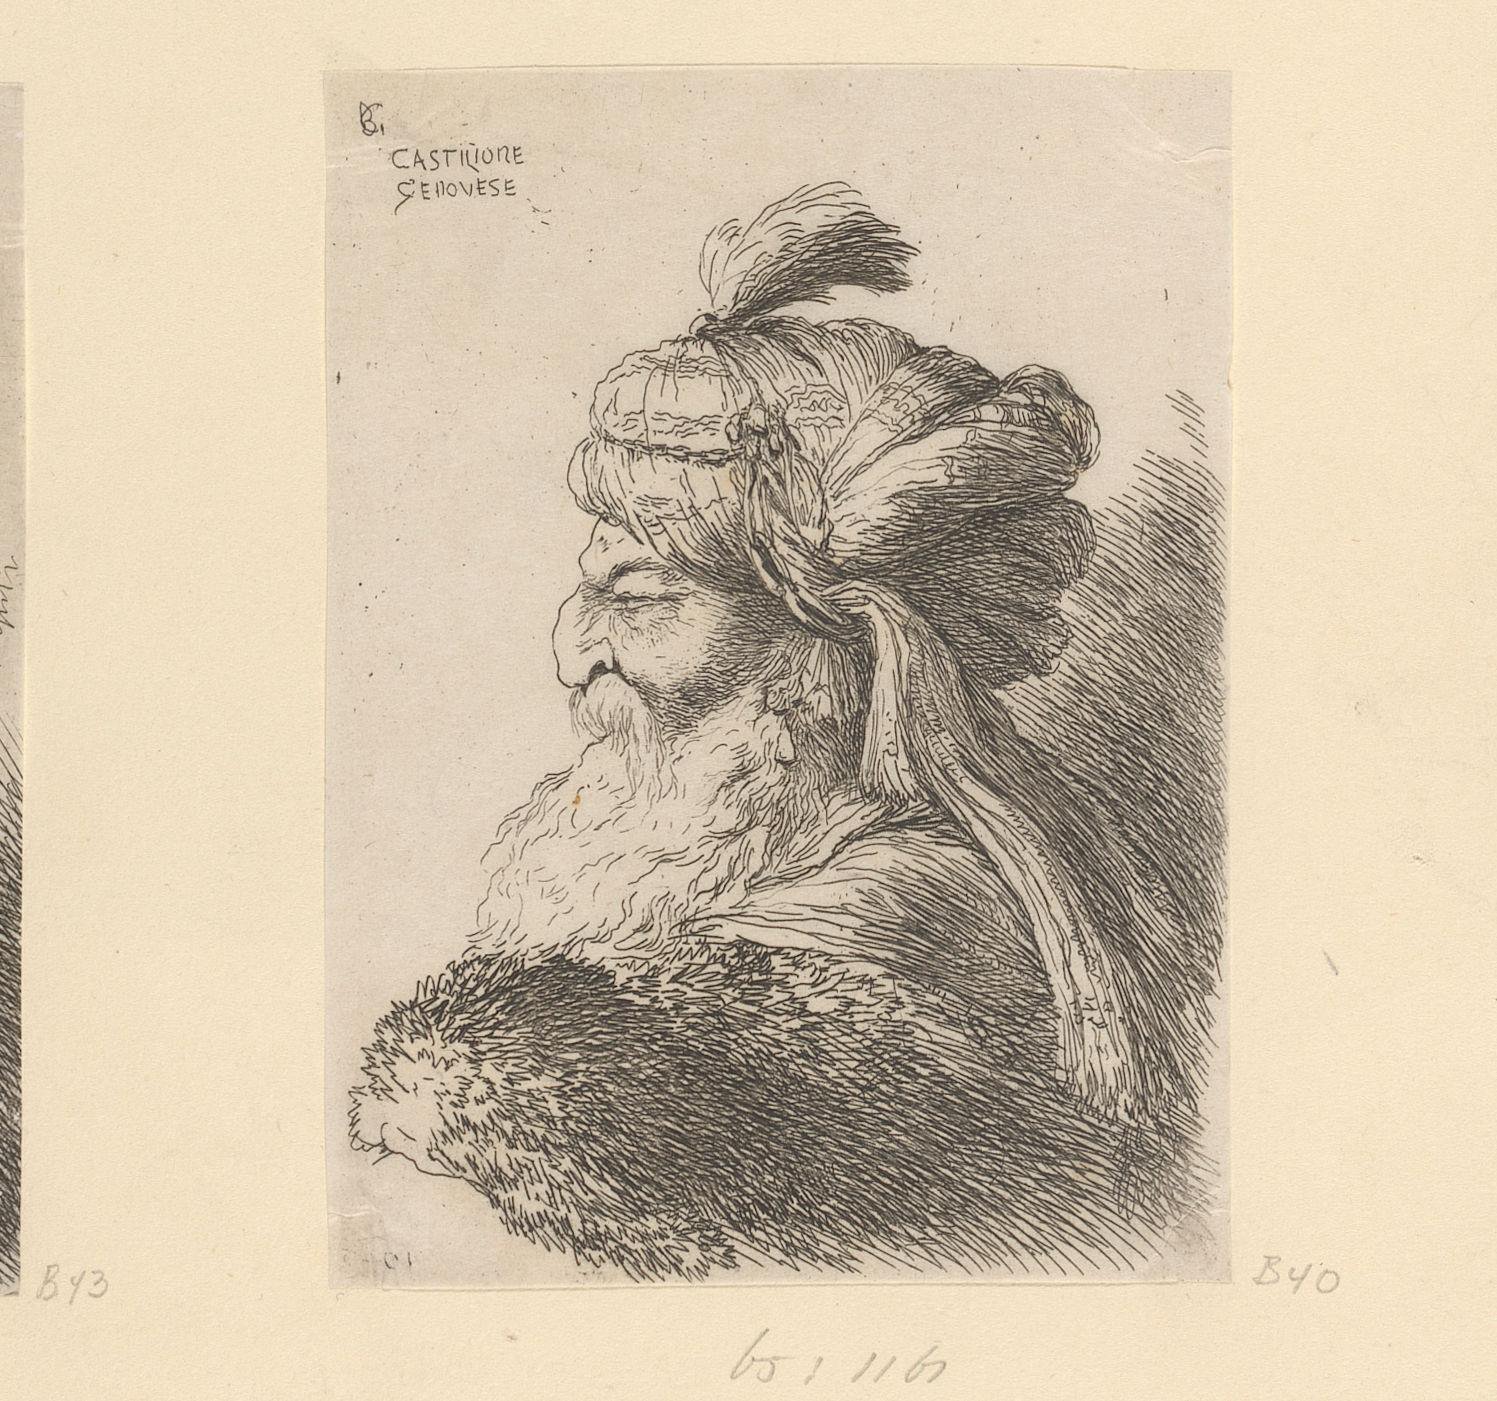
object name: album leaf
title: Hoofd van een oude man met tulband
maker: giovanni benedetto castiglione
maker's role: draughtsman, print maker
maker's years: 1610-1665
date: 1645-1650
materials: paper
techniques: etching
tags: head (human), head-gear: turban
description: Prent is onderdeel van een serie van zestien prenten. Prent maakt mogelijk deel uit van een serie van 200 prenten. Deze serie is onder de titel 'A Collection of two hundred original etchings' voor het eerst uitgegeven door J.M. Greery in 1816.